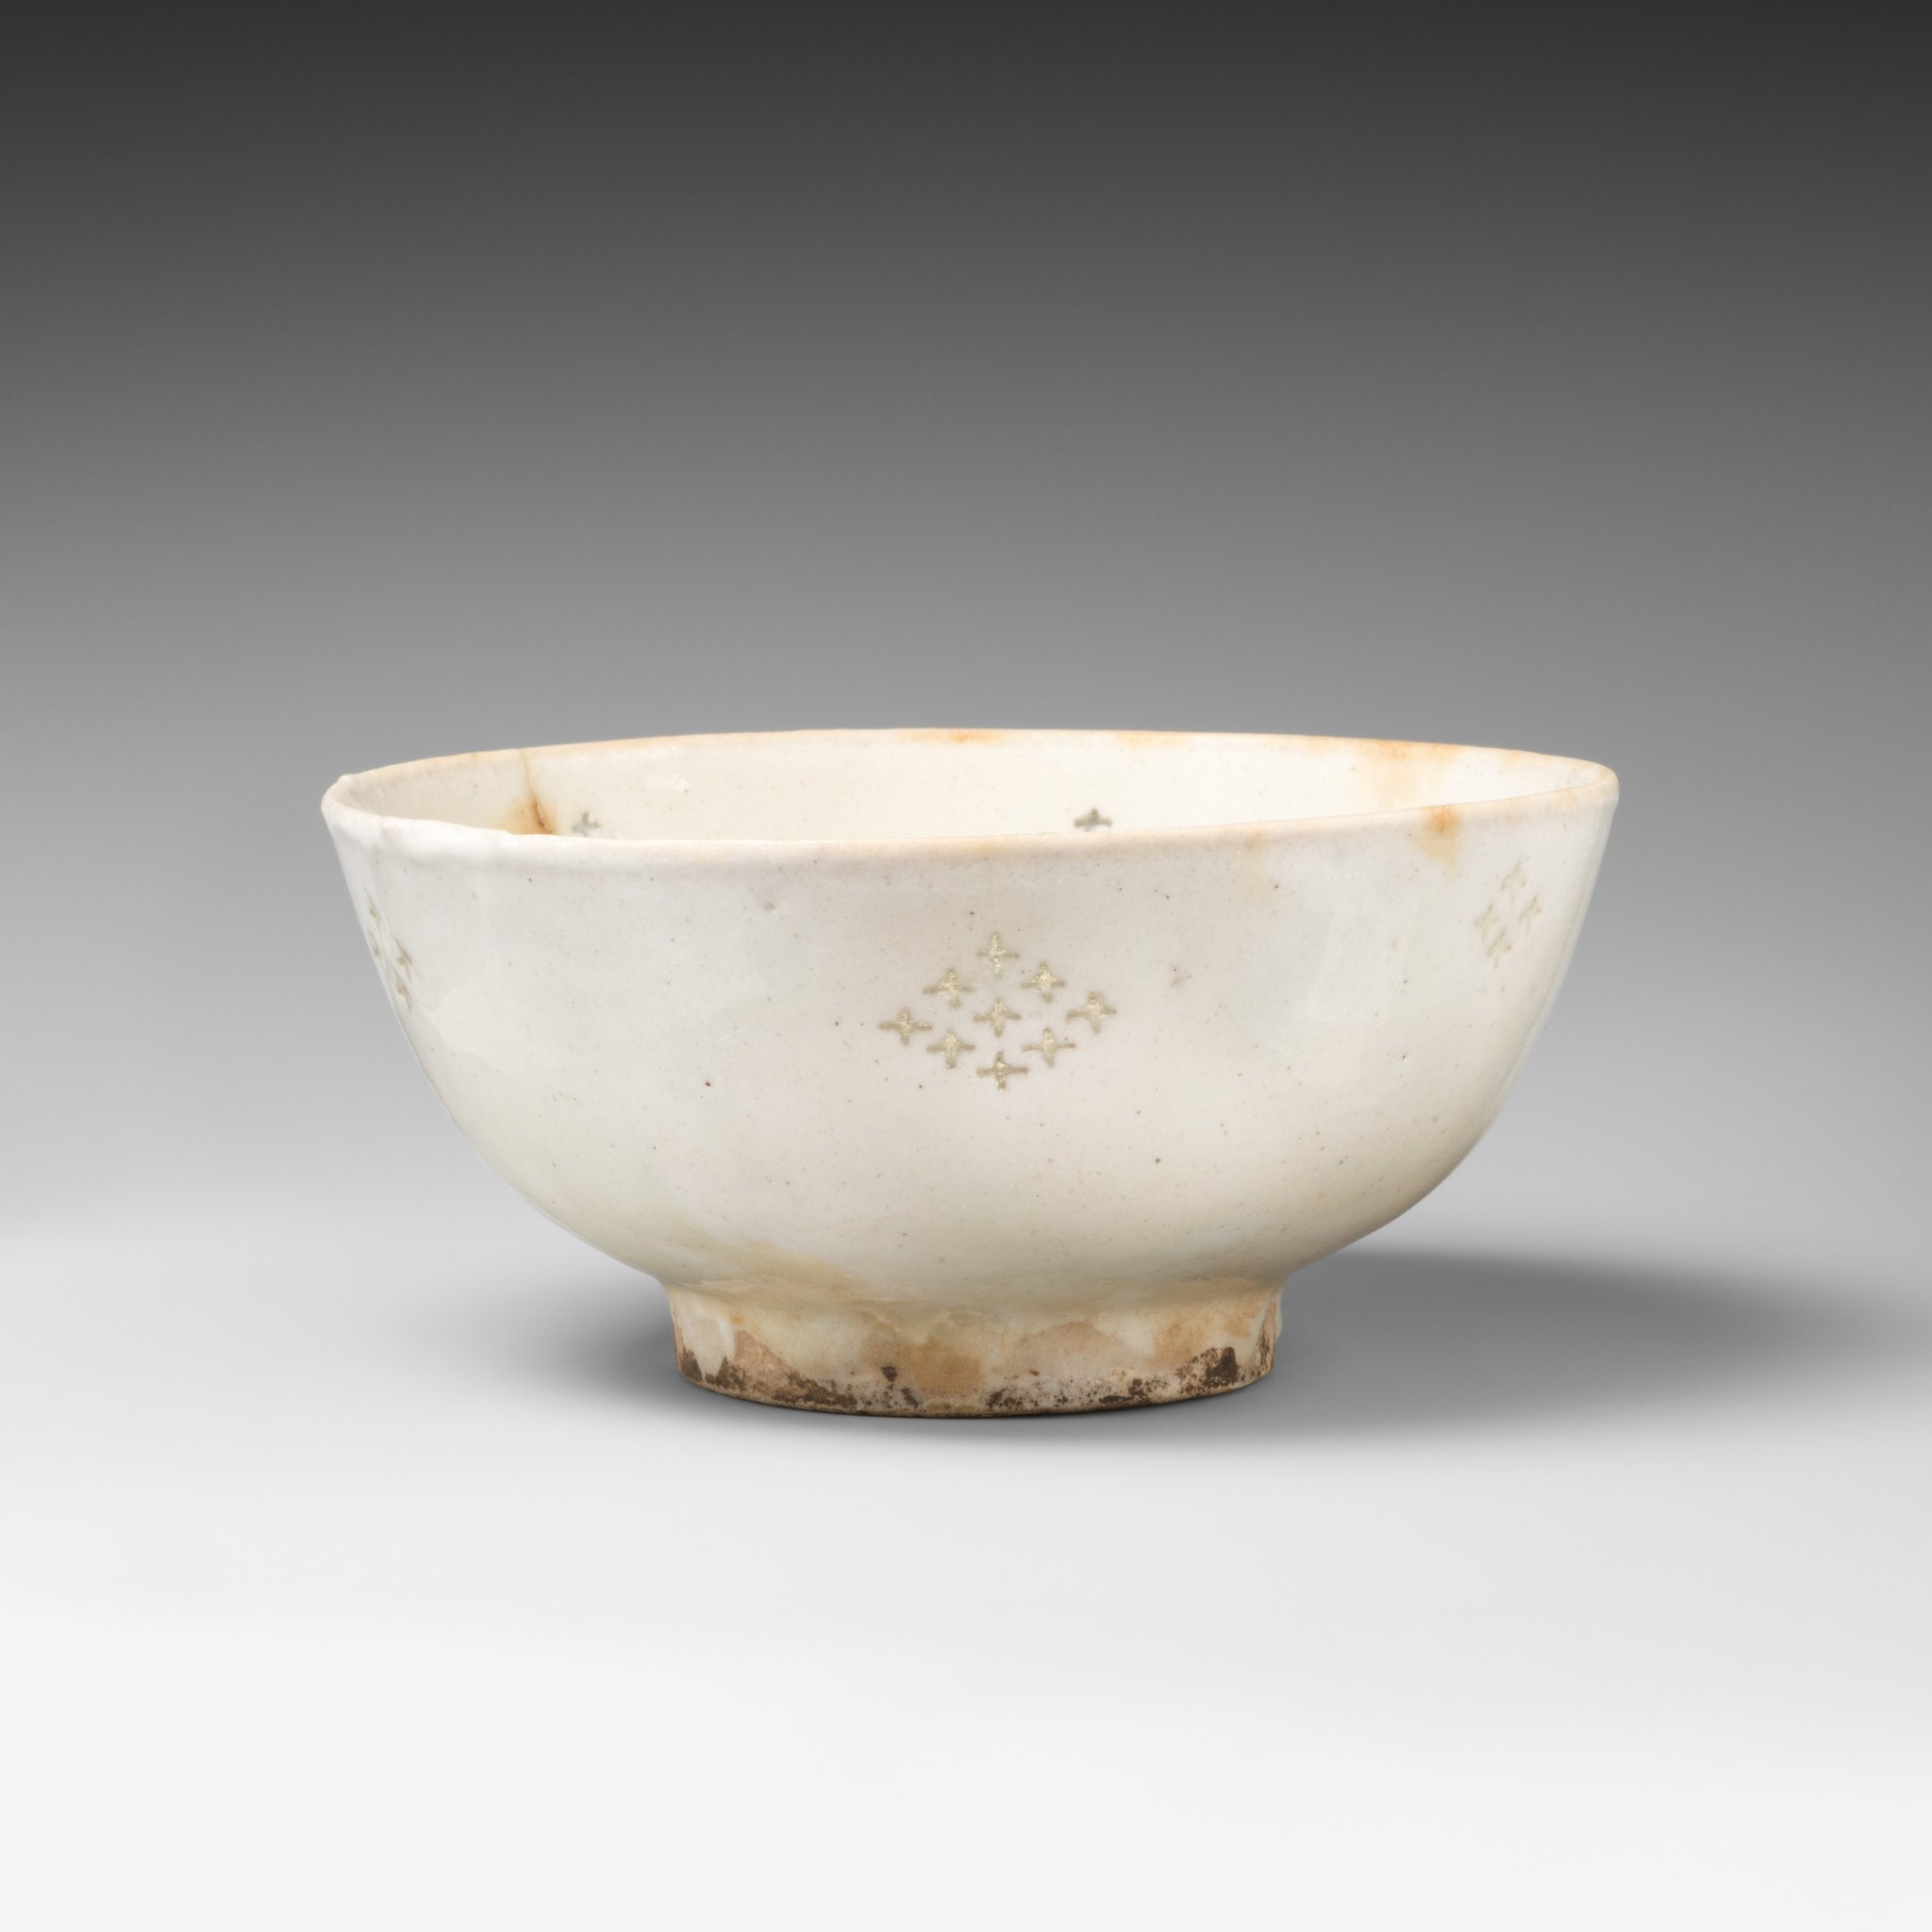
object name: bowl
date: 1701-1750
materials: stonepaste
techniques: glazing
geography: iran